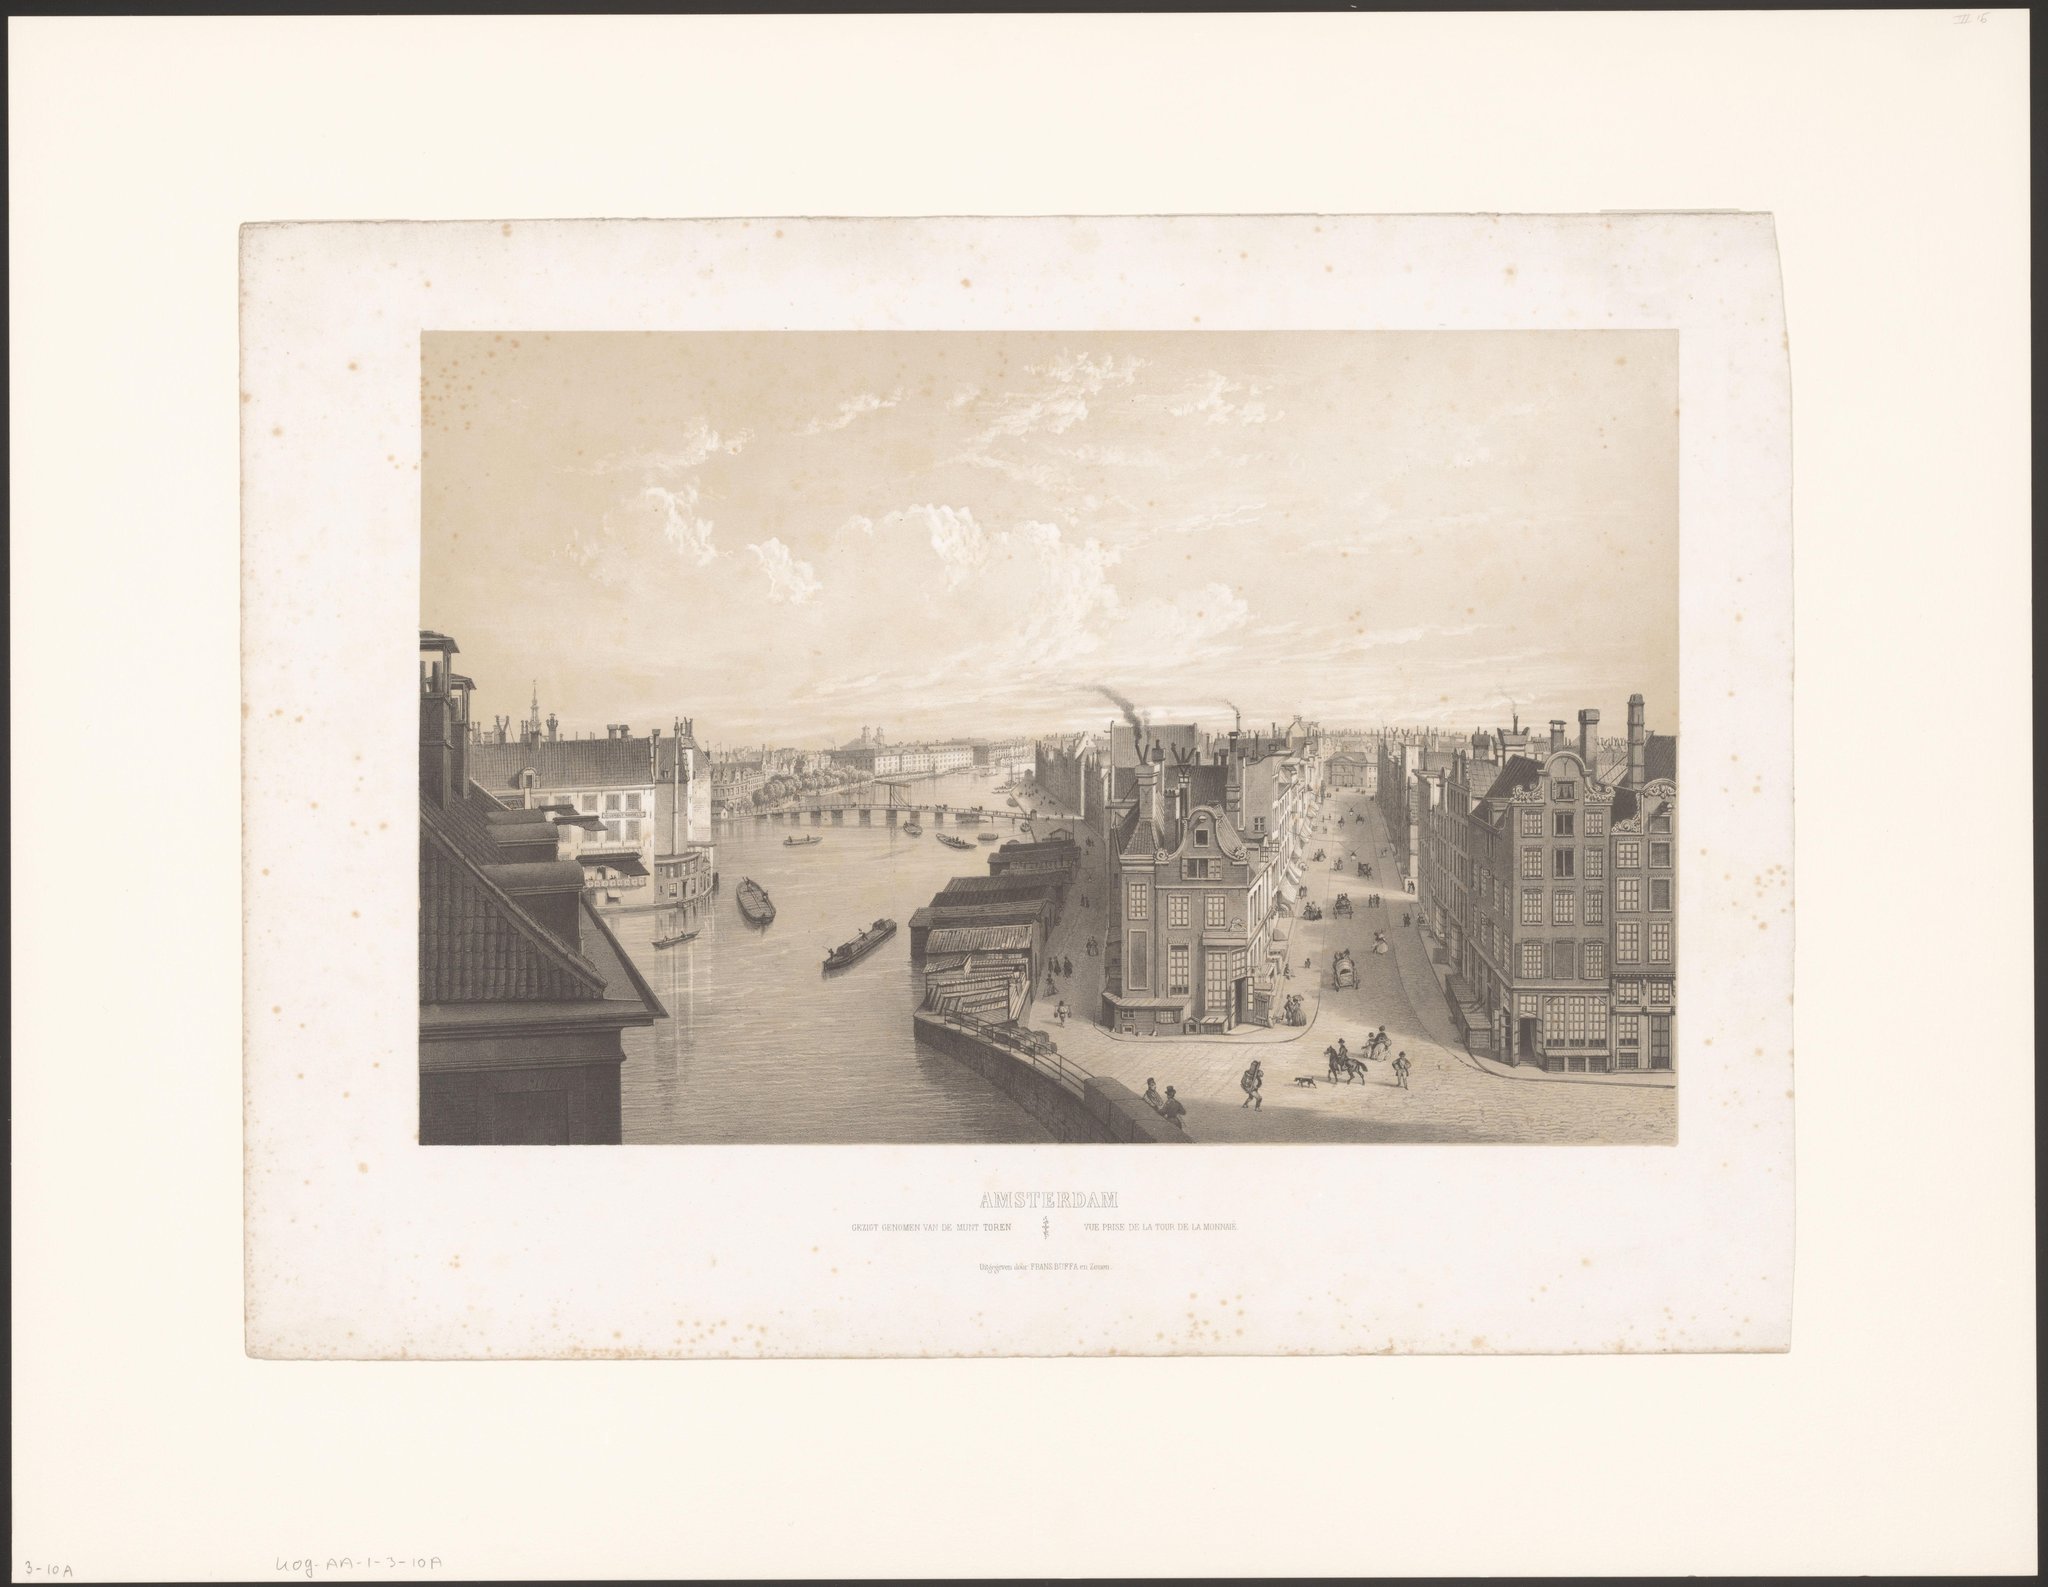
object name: print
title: Gezichten in Amsterdam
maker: Anonymous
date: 1836-1875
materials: paper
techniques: tone lithography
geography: amsterdam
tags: river, the usual house or row of houses, bridge in city across river, canal, etc., street, prospect of city, town panorama, silhouette of city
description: Onderwerpsrubriek binnen de Atlas Amsterdam: Panorama's en verzamelprenten.